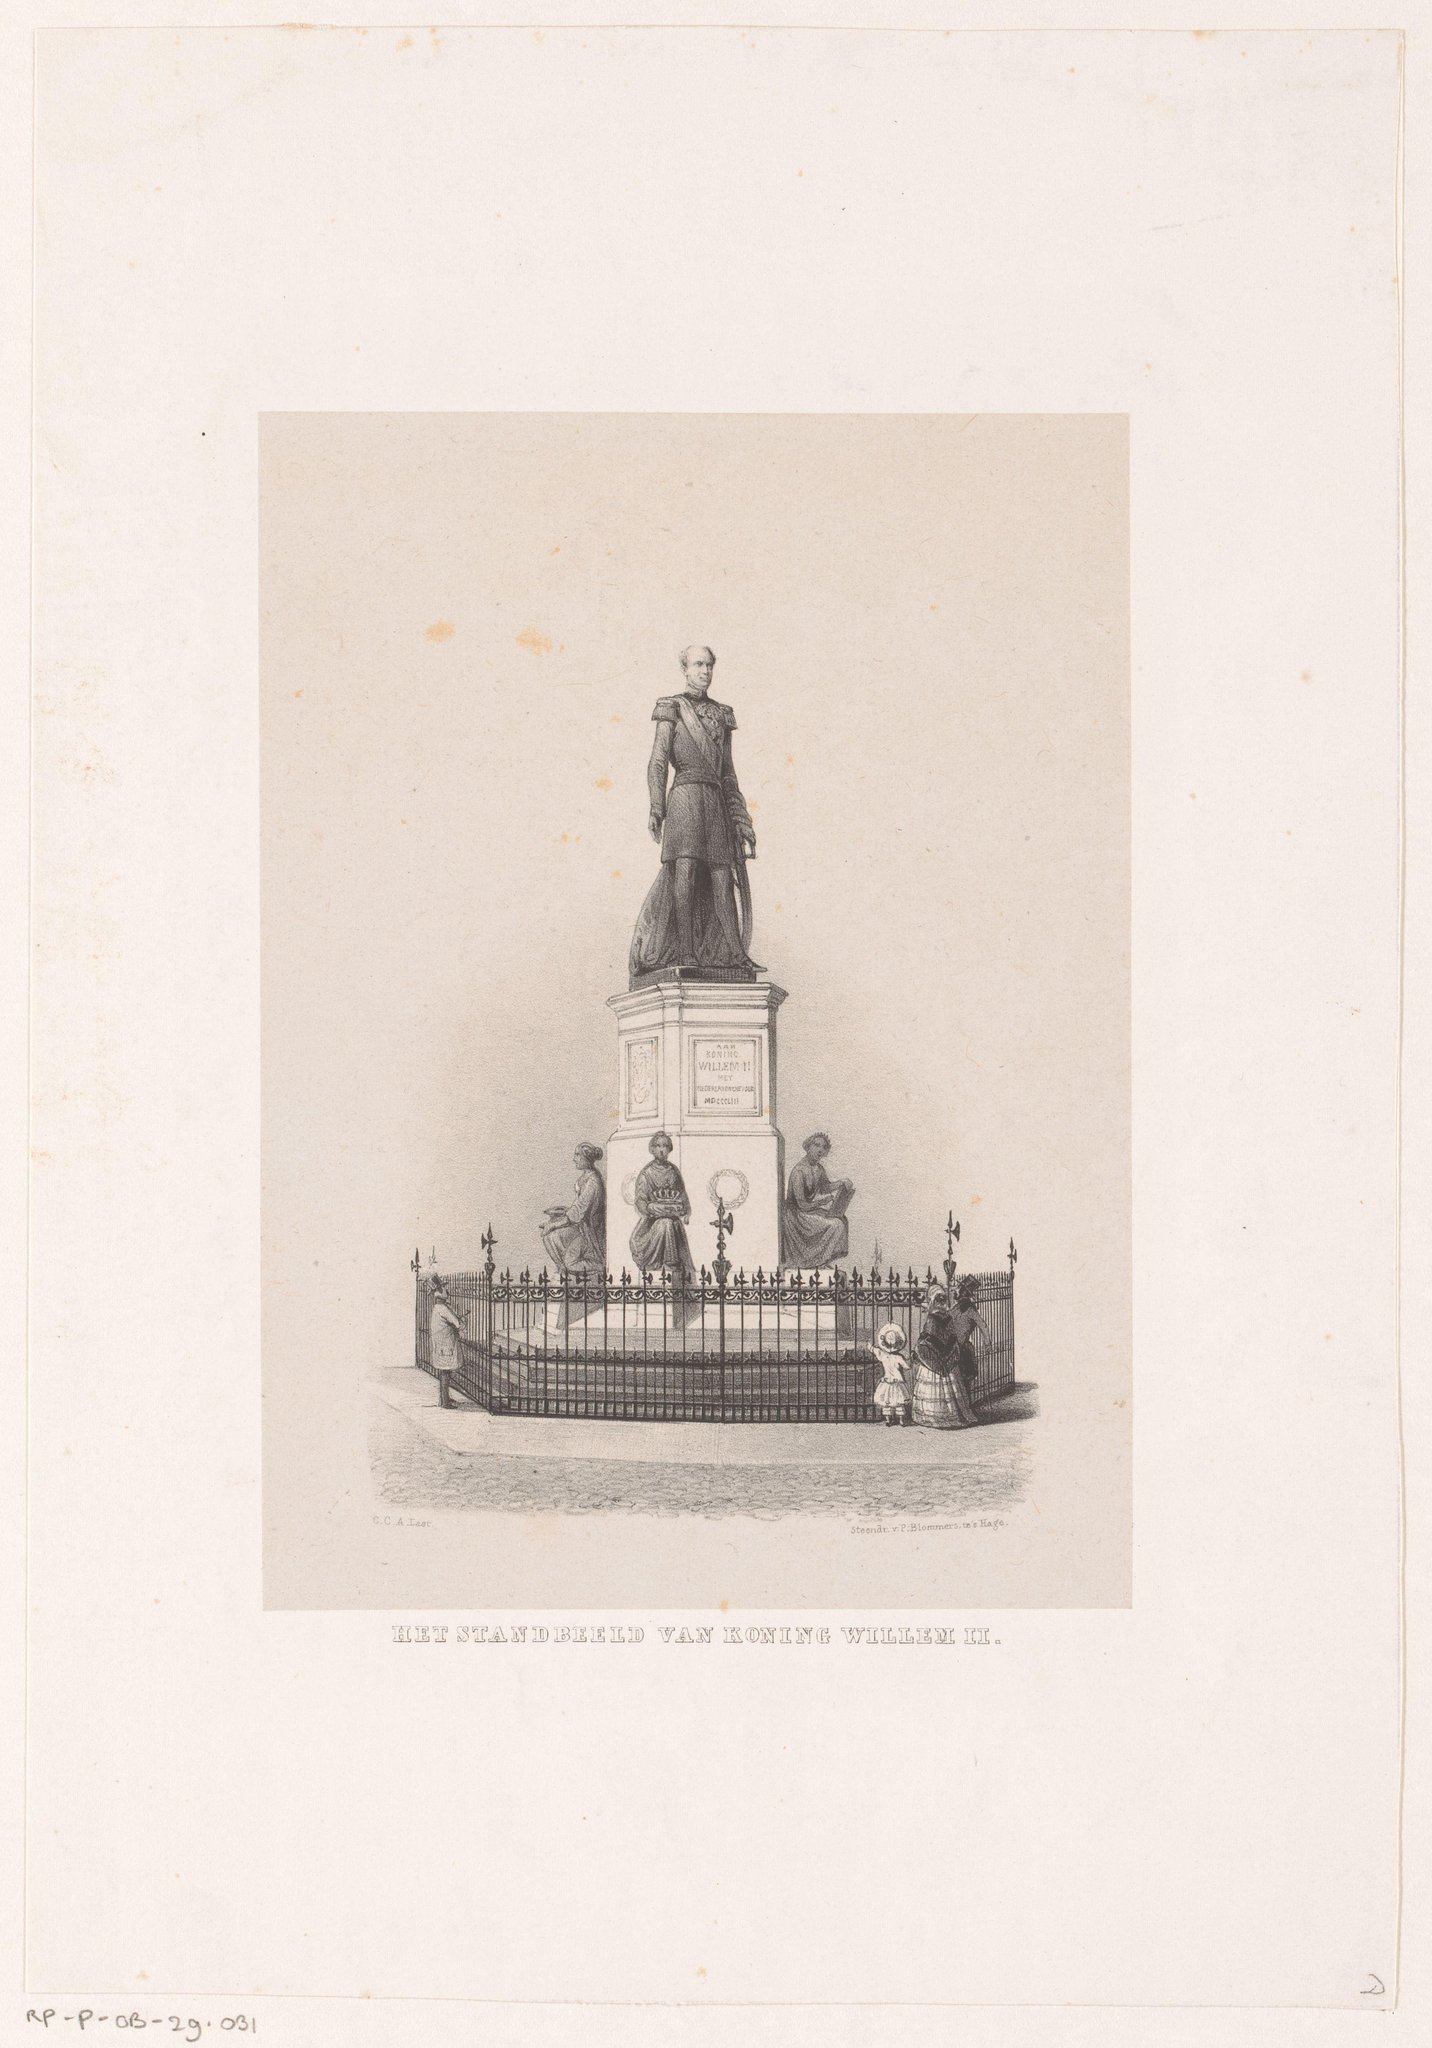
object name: print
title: Het standbeeld van Koning Willem II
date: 1854-1887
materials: paper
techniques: lithograph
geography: the hague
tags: the hague, william ii of the netherlands, piece of sculpture, reproduction of a piece of sculpture, monument, statue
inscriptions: collector's mark: Lugt 2228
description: Het beeld van Koning Willem II staat op een sokkel met daar omheen vier vrouwenfiguren. Zichtbaar zijn drie allegorieën op het koningschap, de wetgeving, en de welvaart. Links voor het hek staat een man naar het standbeeld te kijken, rechts een gezin.